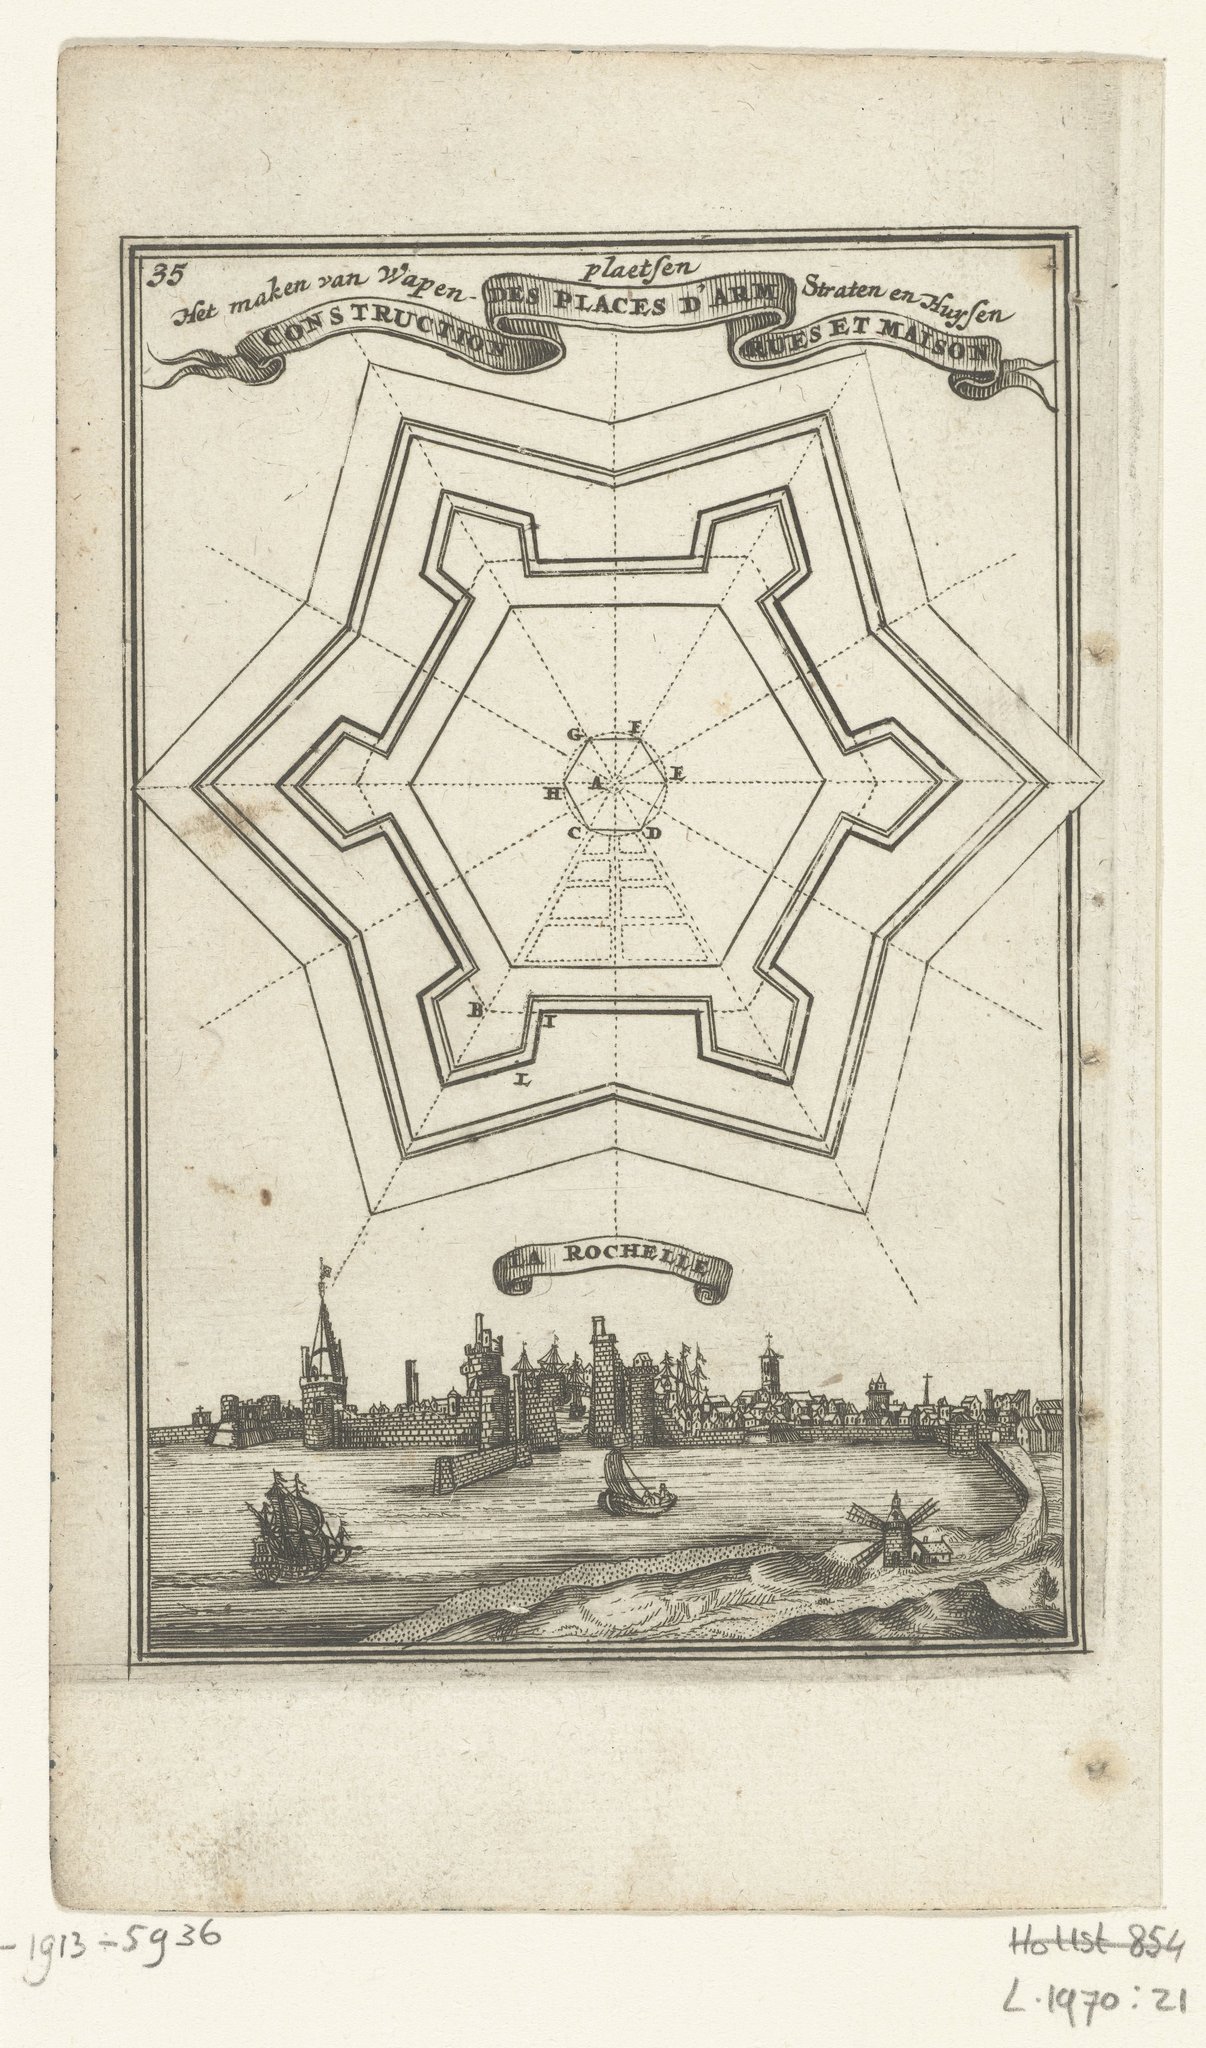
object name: book illustration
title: Illustratie voor 'Den Arbeid van Mars' van Allain Manesson Mallet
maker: romeyn de hooghe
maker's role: draughtsman, goldsmith, painter, print maker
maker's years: 1645-1708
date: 1672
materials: paper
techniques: etching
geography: amsterdam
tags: landscapes with waters, waterscapes, seascapes (in the temperate zone), fortifications, military engineering, prospect of city, town panorama, silhouette of city, mathematics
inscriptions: collector's mark: Lugt 2228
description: Grondplan voor een vesting, fort of versterking (zeshoek). Daaronder gezicht op een stad aan het water (La Rochelle). In de hoek linksboven het cijfer 35 (= het nummer van de pagina in het boek waartegenover de illustratie geplaatst is).